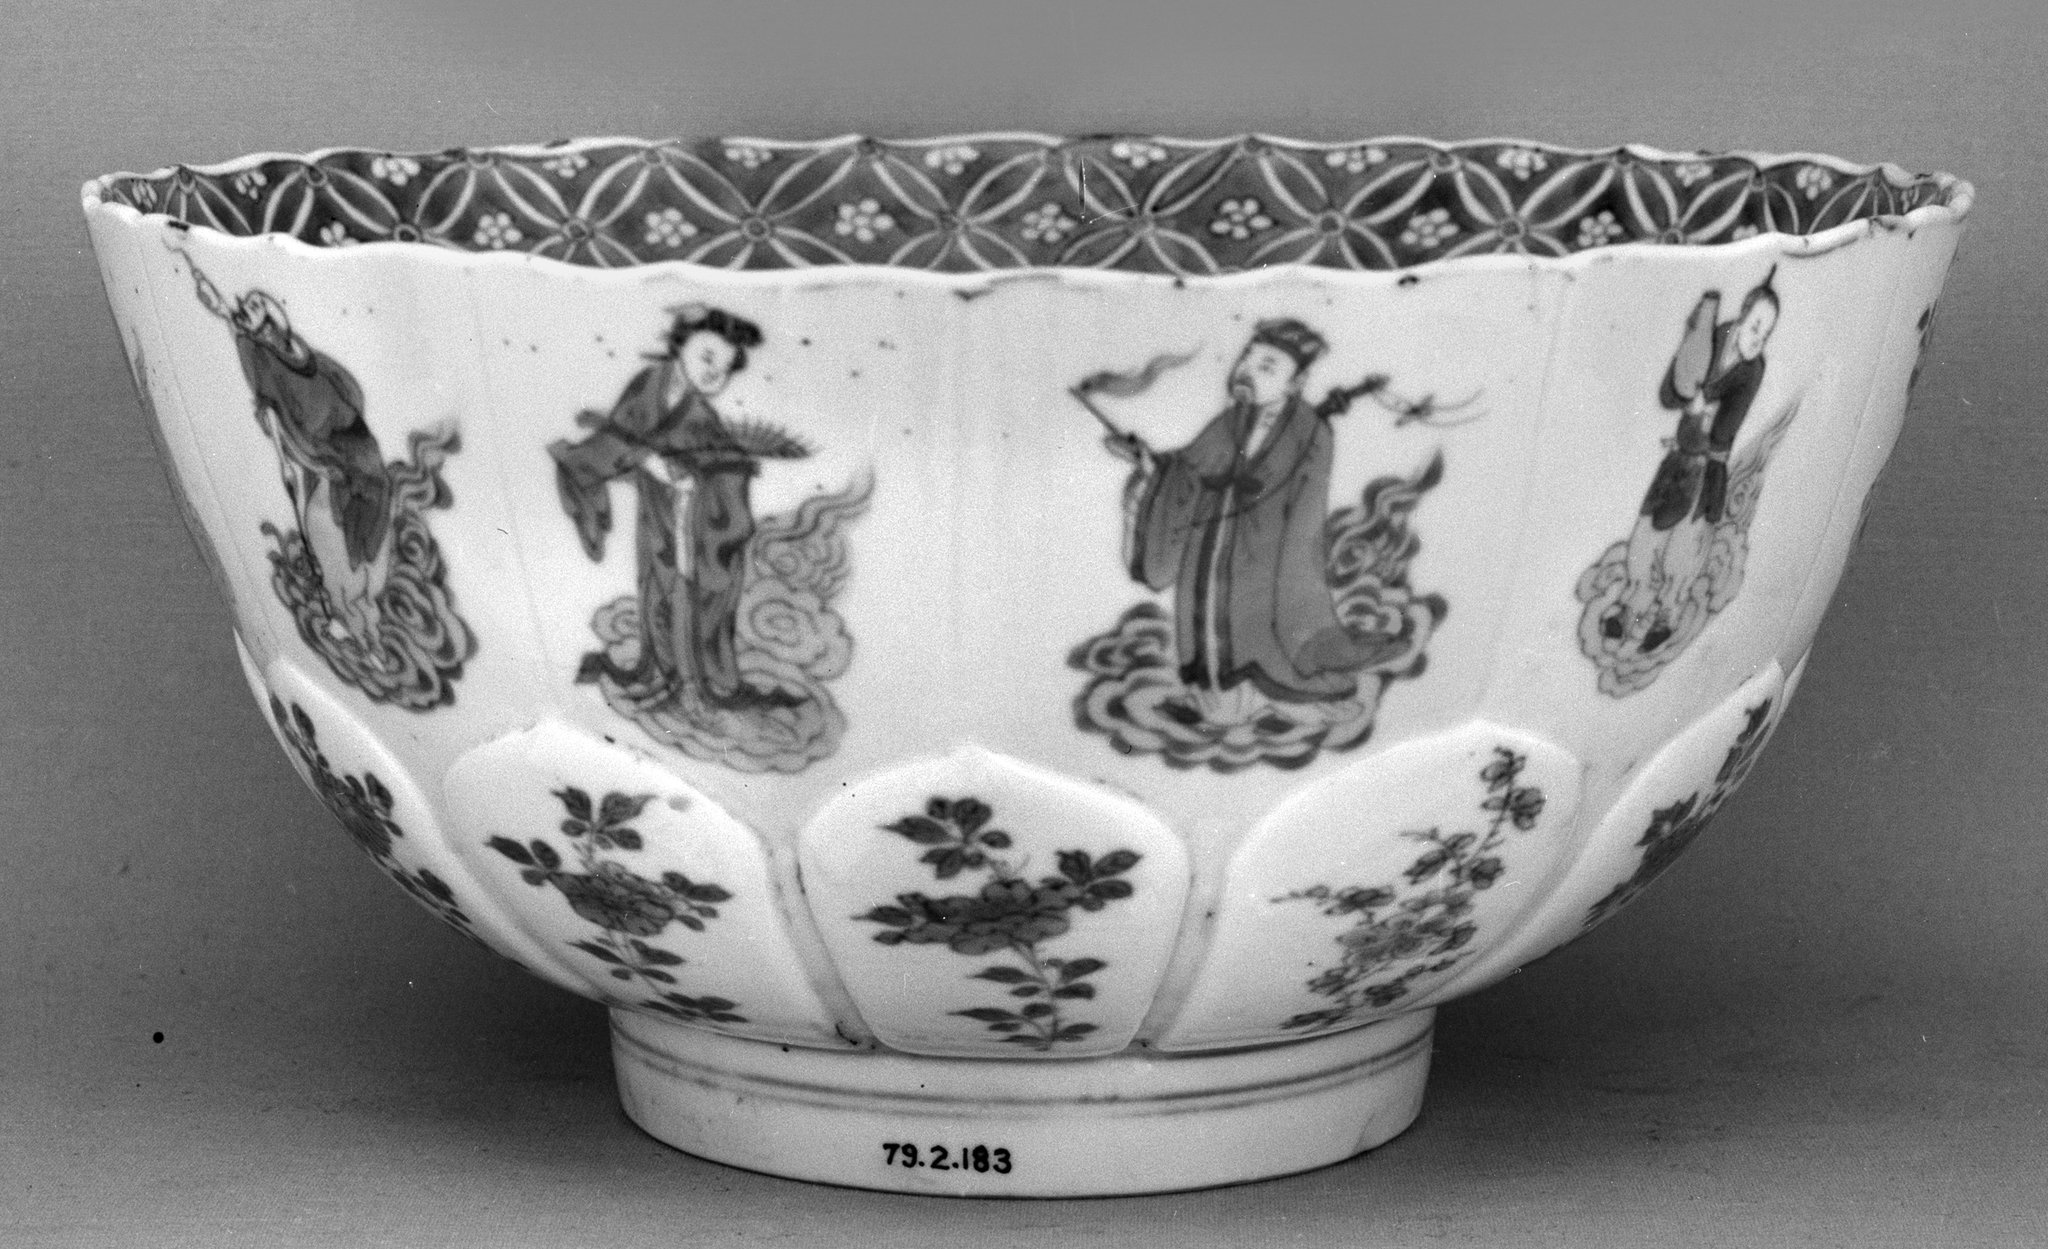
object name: bowl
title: Lotus bowl with immortals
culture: chinese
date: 1667-1733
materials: cobalt, porcelain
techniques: painting, underglaze